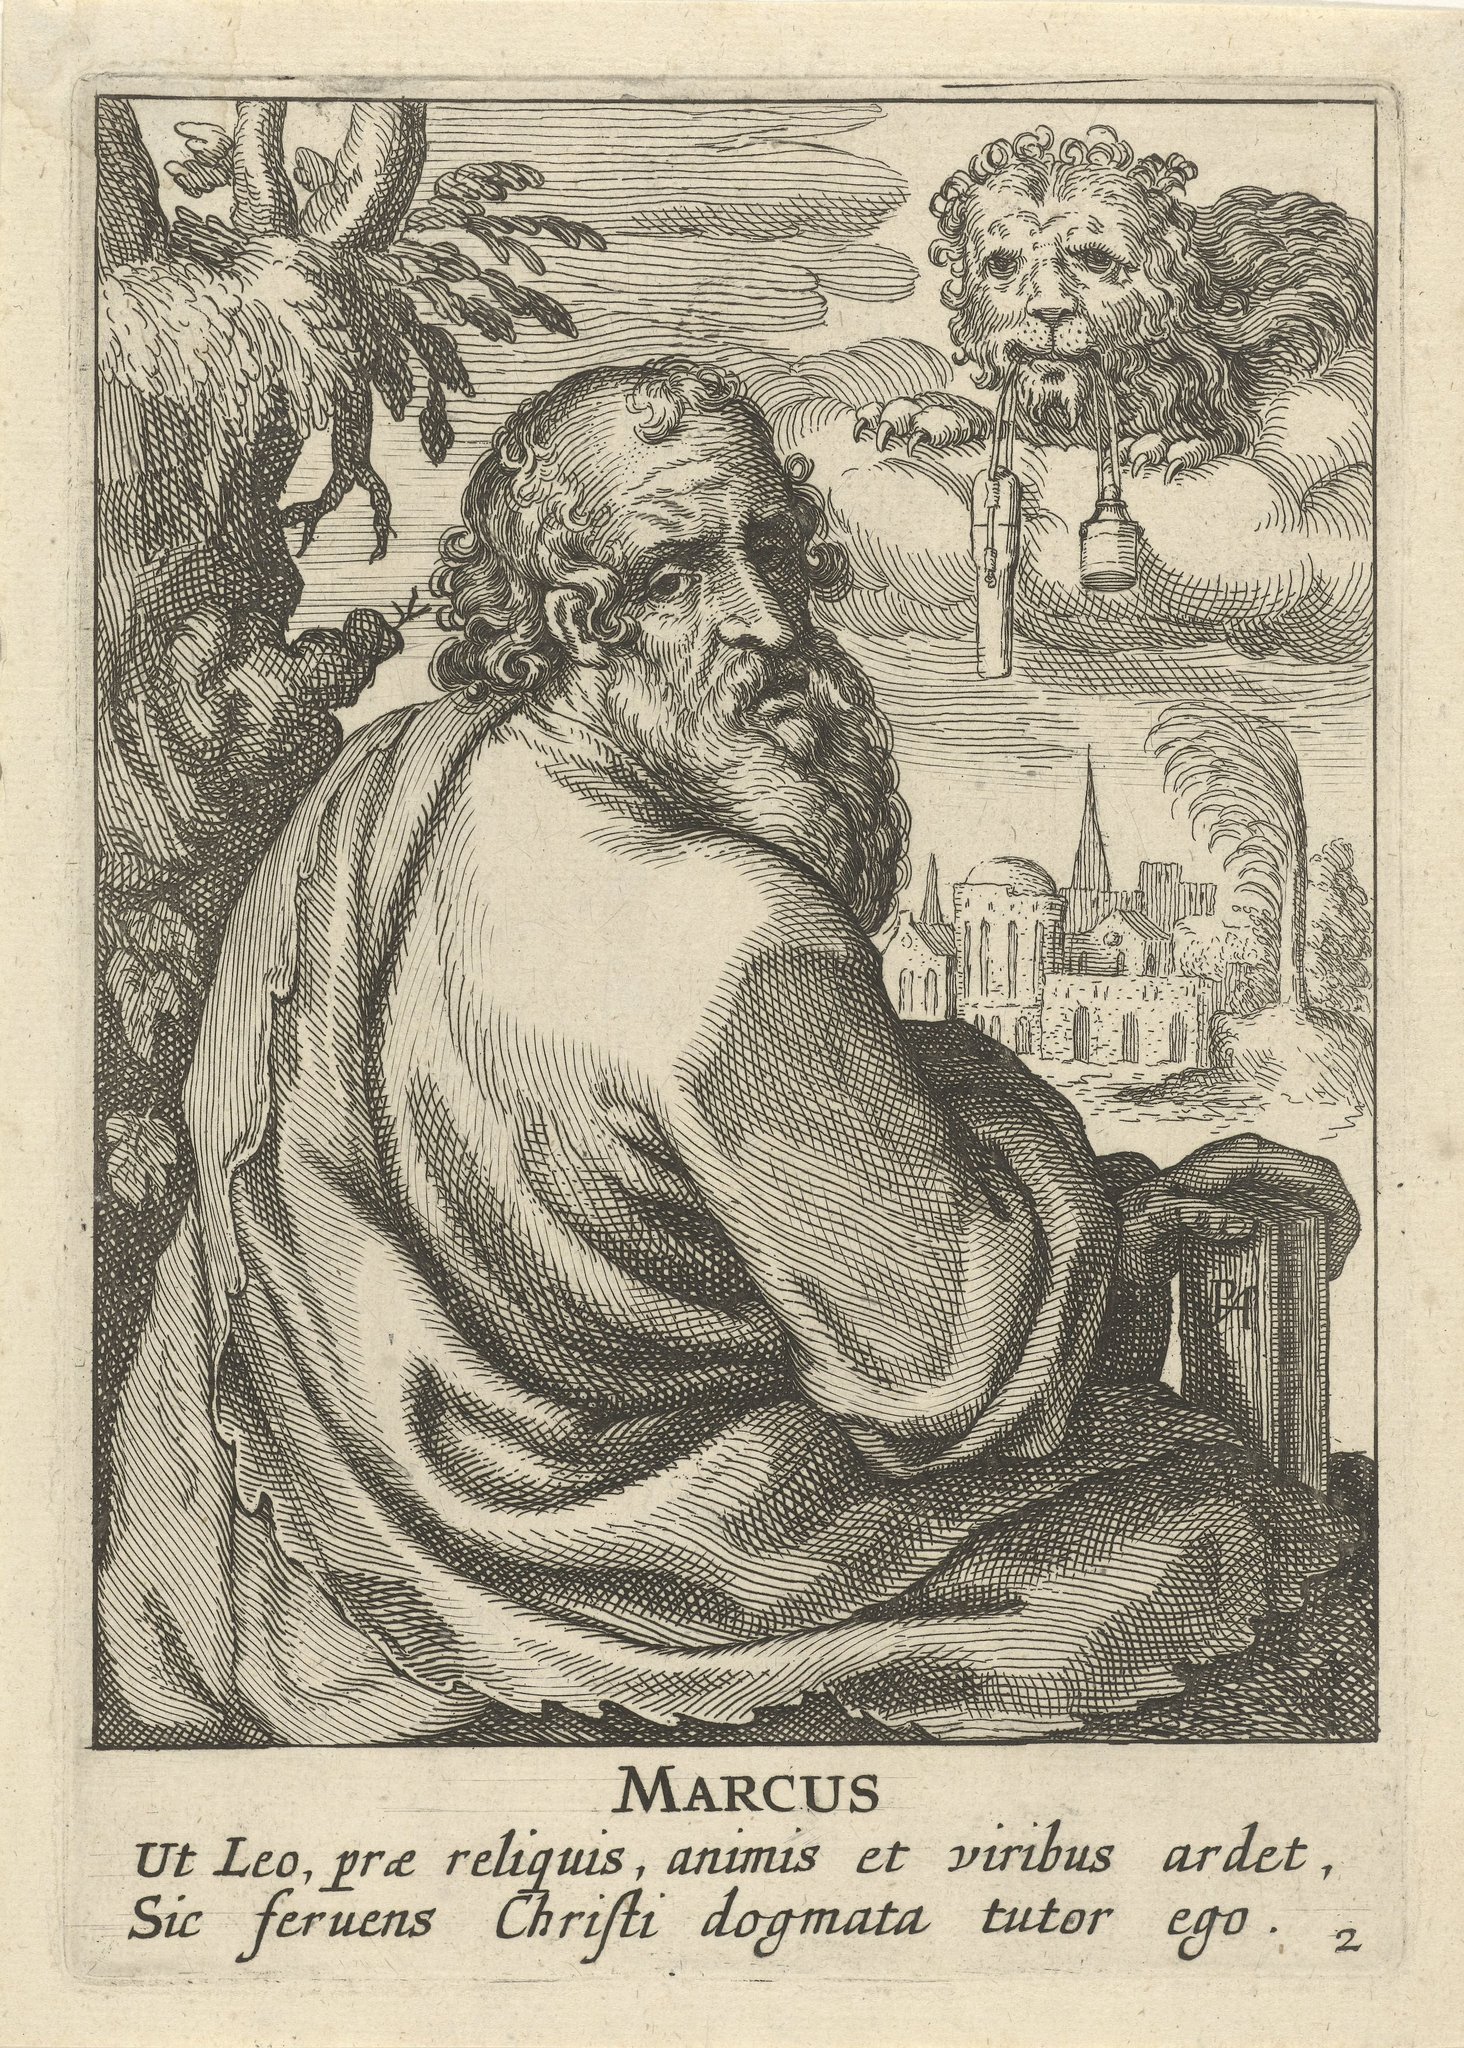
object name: print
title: Marcus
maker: pieter feddes van harlingen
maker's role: painter, print maker, publisher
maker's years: 1586-1623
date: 1611-1623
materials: paper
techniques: etching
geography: friesland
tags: mark (marcus) the evangelist, and bishop of alexandria; possible attributes: book, (winged) lion, pen and inkhorn, scroll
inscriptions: collector's mark: Lugt 2228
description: Marcus de evangelist zit tegen een boom aan met een boek in zijn handen. Boven hem zijn attribuut: een leeuw, met een inkpot en schrijfgerei in de bek. Op de achtergrond een stad. Onder de voorstelling een opschrift in Latijn.